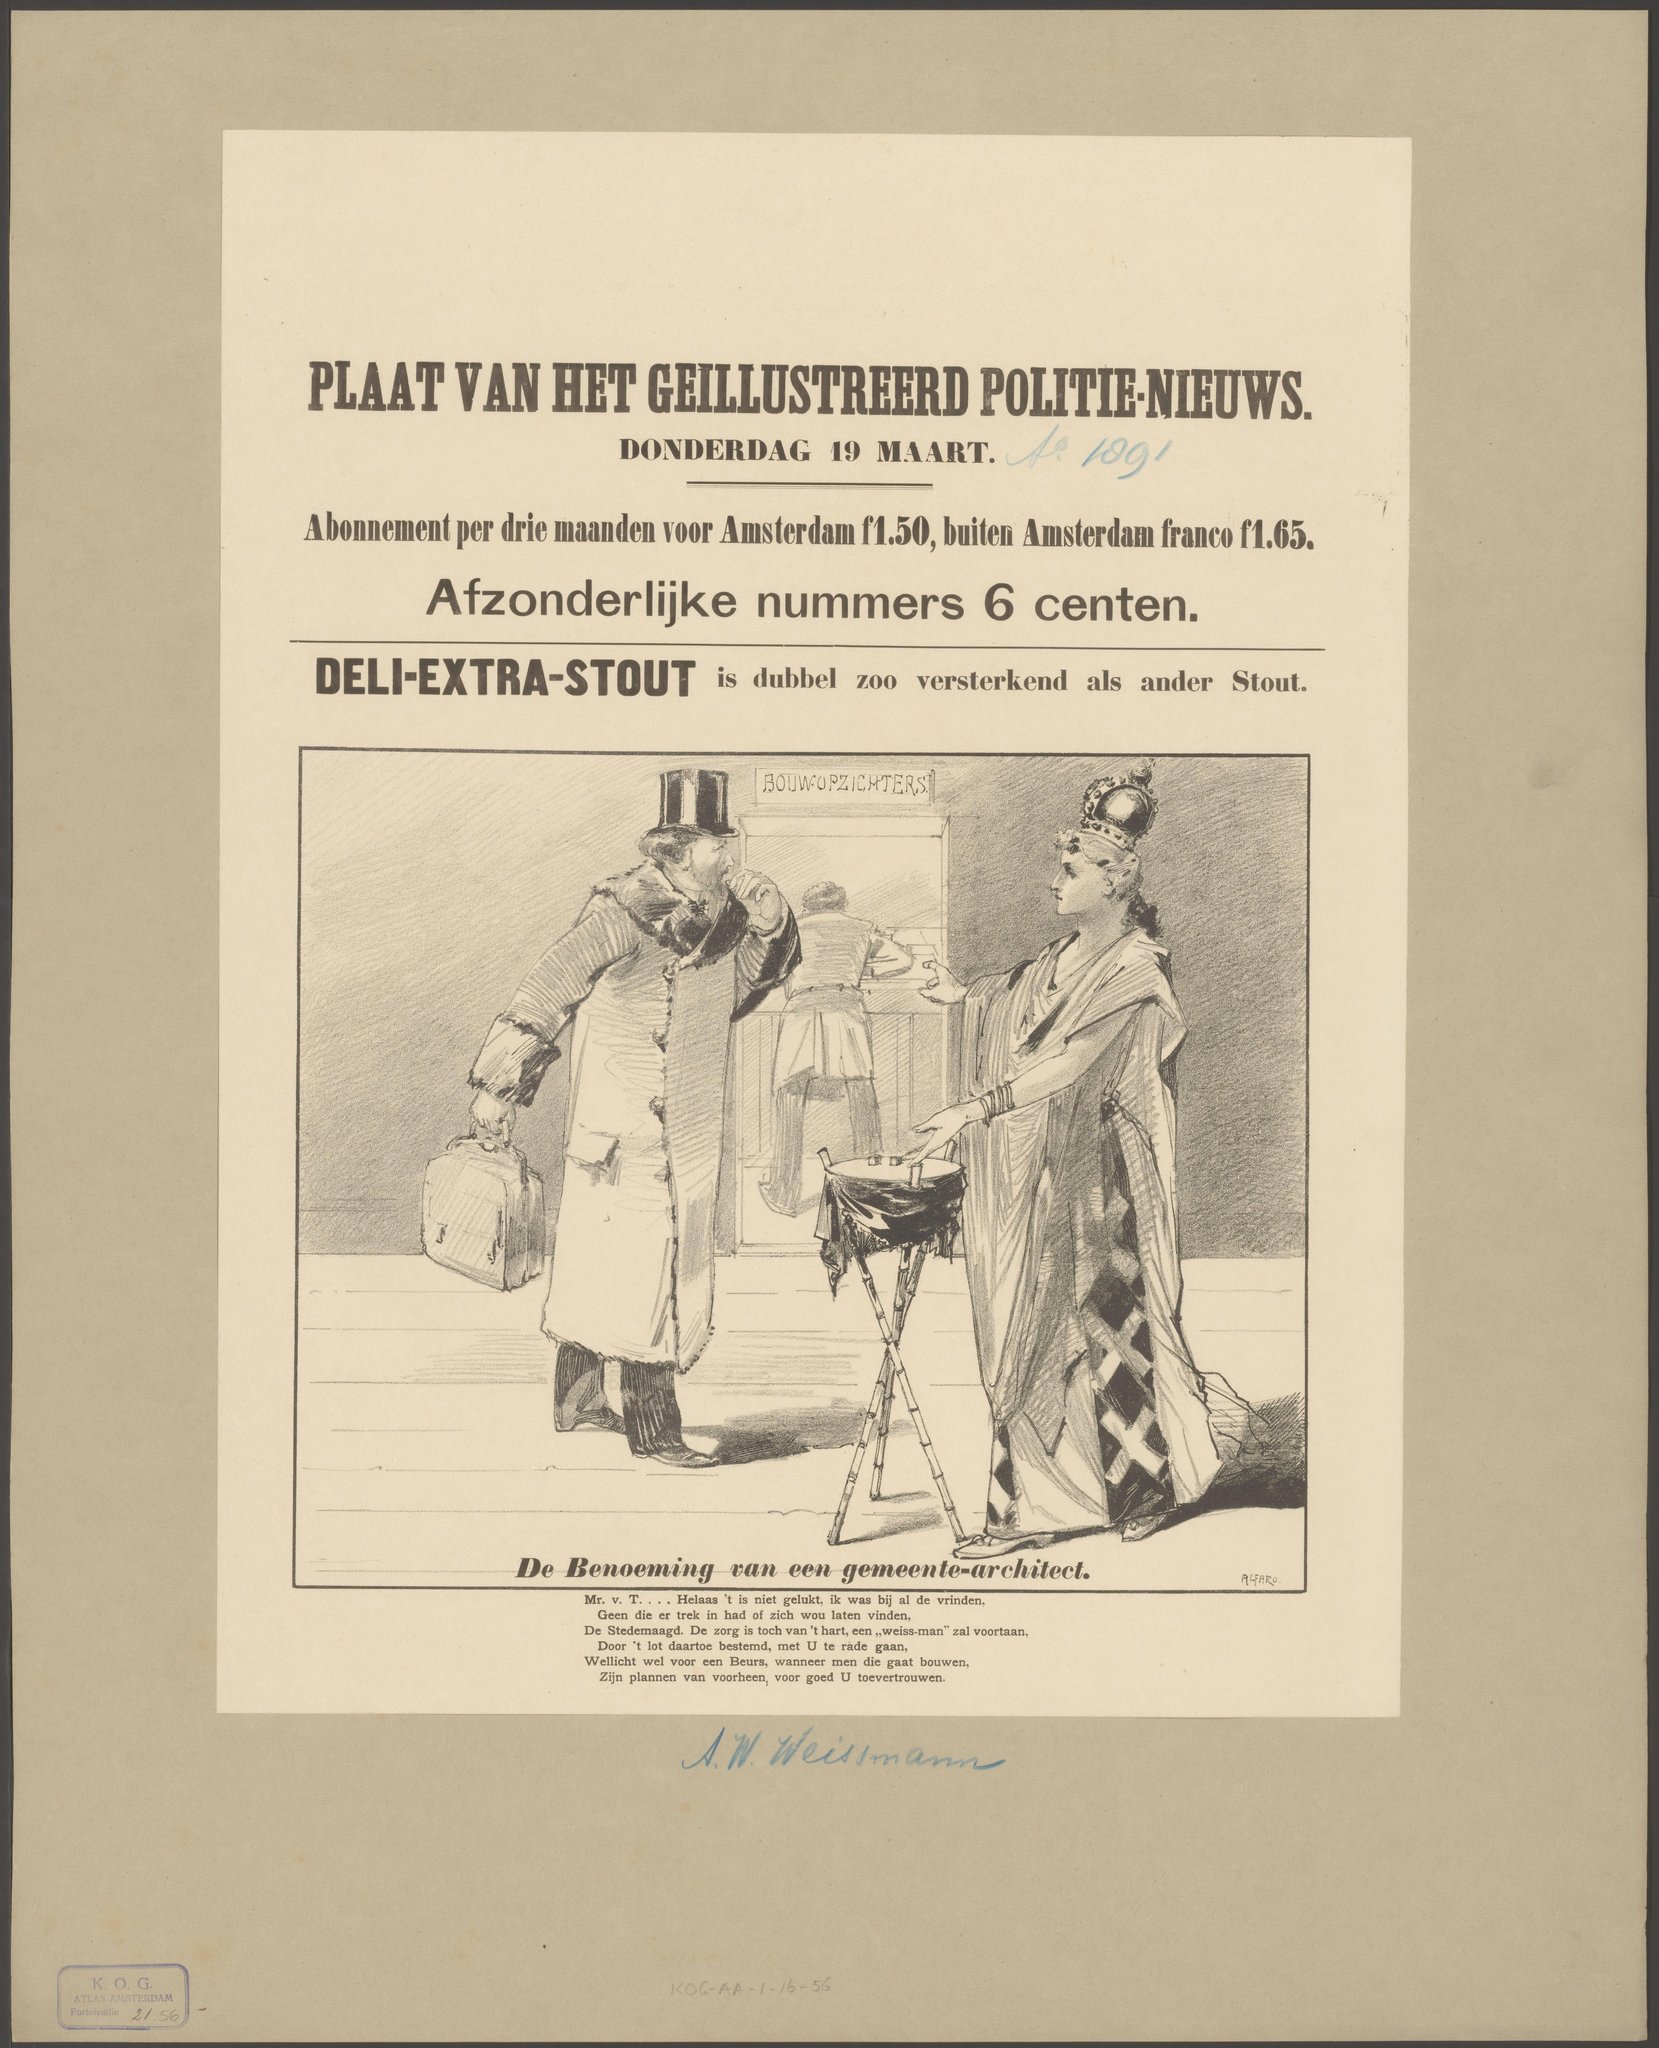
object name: print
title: Amsterdamse stedenmaagd wijst Adriaan Willem Weissman naar bouwopzichters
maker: alfaro reijding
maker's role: draughtsman, engineer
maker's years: 1863-1930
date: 1891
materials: paper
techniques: letterpress printing, lithograph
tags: adriaan willem weissman, political caricatures and satires, amsterdam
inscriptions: collector's mark: ‘21.56’ Lugt 1641b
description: Onderwerpsrubriek binnen de Atlas Amsterdam: Herinneringen aan ambtenaren.